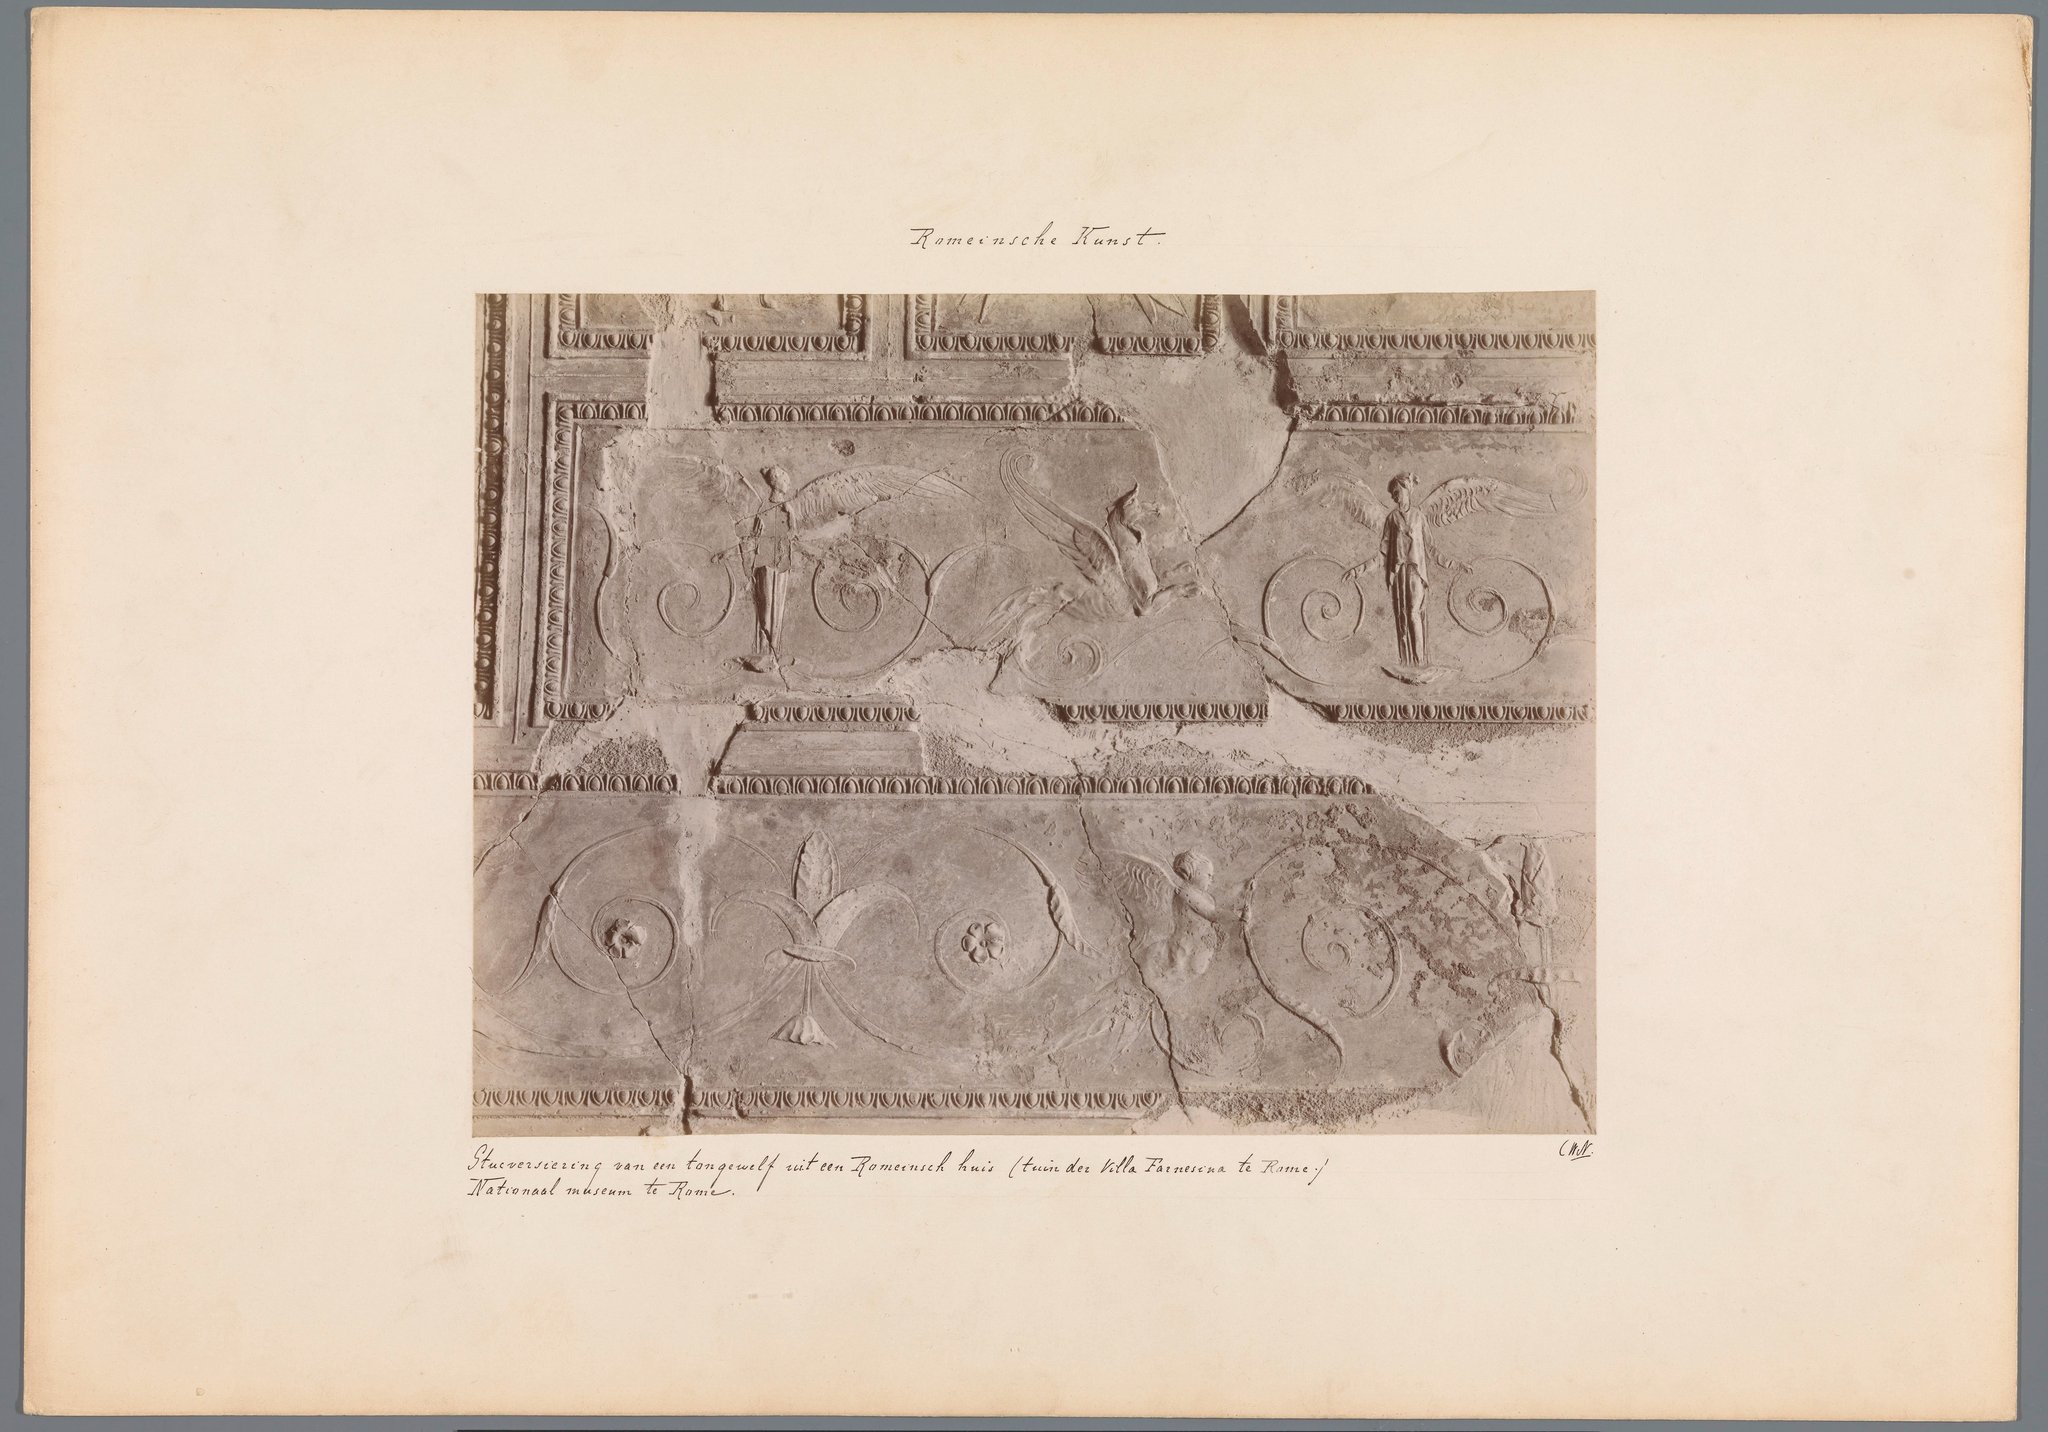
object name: photograph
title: Stucversiering van de Villa Farnesina in het Museo Nazionale Romano te Rome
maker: Anonymous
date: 1870-1900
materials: cardboard, photographic support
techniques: albumen print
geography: museo nazionale romano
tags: fabulous beings with wings - aa - female human figure, ornament ~ hybrid animals, ornament derived from plant forms, sculpture (+ relief ~ sculpture)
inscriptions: inscription: ‘Romeinsche Kunst. Stucversiering van een tongewelf uit een Romeinsch huis (tuin der Villa Farnesina te Rome.) Nationaal museum te Rome.’, collector's mark: ‘INSTITUUT VOOR KUNST- NIJVERHEIDSONDERWIJS GABRIËL METSUSTRAAT No. 16. AMSTERDAM’, inscription: ‘CWN’, collector's mark: ‘KUNSTNIJVERHEIDSCHOOL QUELLINUS AMSTERDAM FRANS HALSSTRAAT 14.’